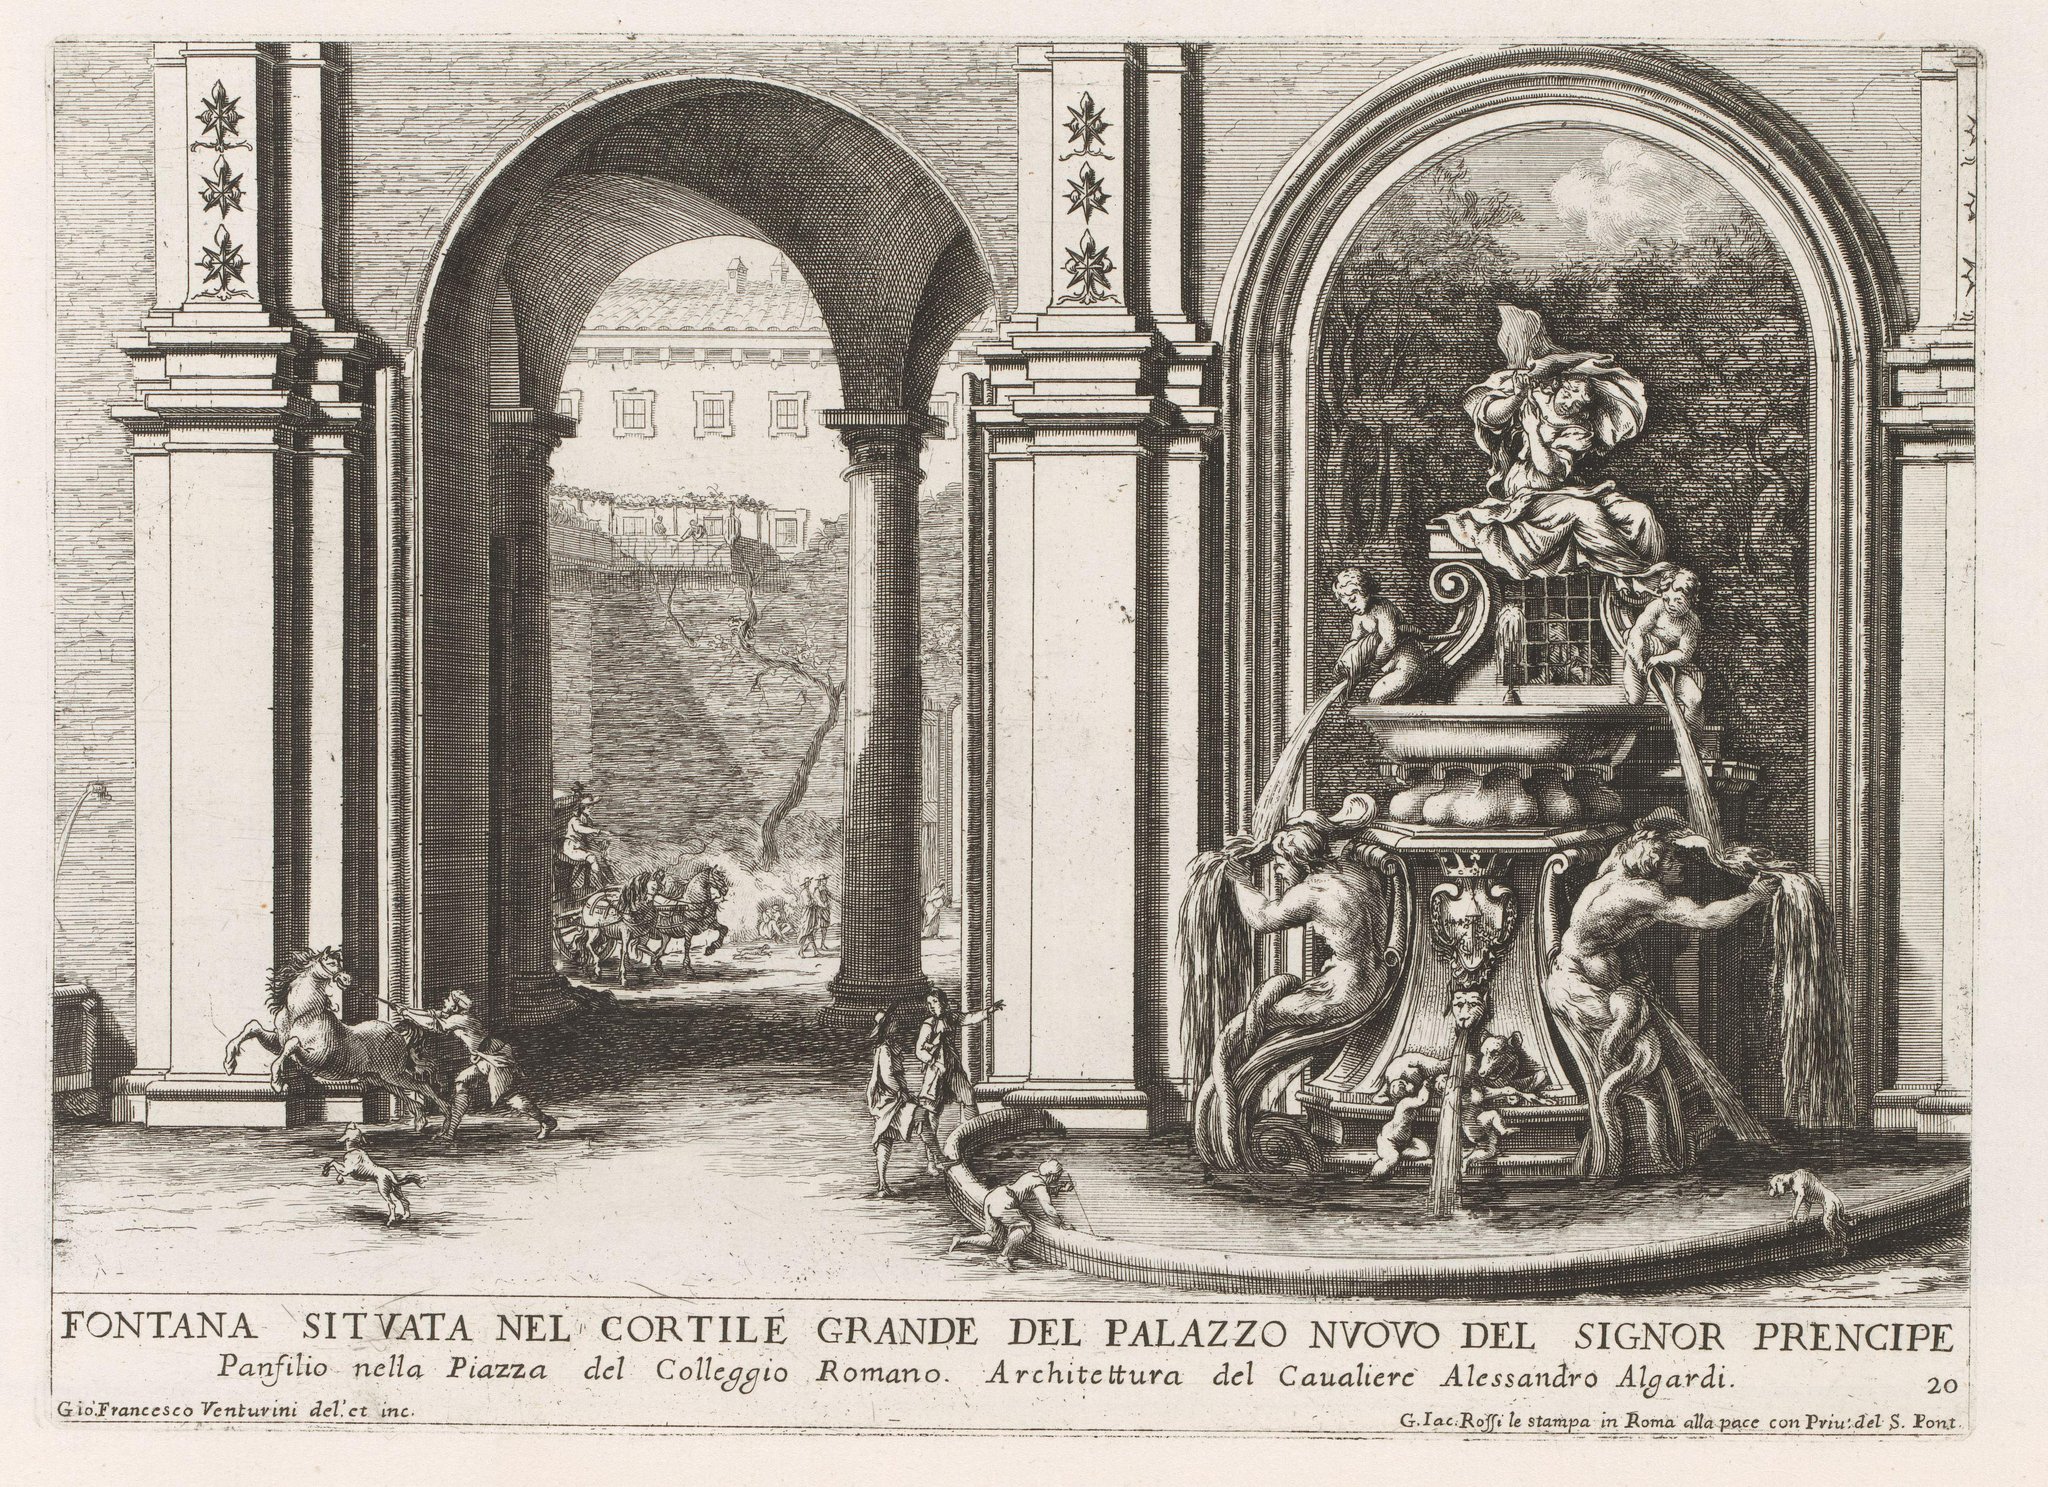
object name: print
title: Fonteinen in de paleizen en tuinen van Rome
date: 1653-1691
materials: paper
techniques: etching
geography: rome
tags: triton(s), ornamental fountain, rome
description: Genummerd rechtsonder: 20. De prent maakt deel uit van een album.